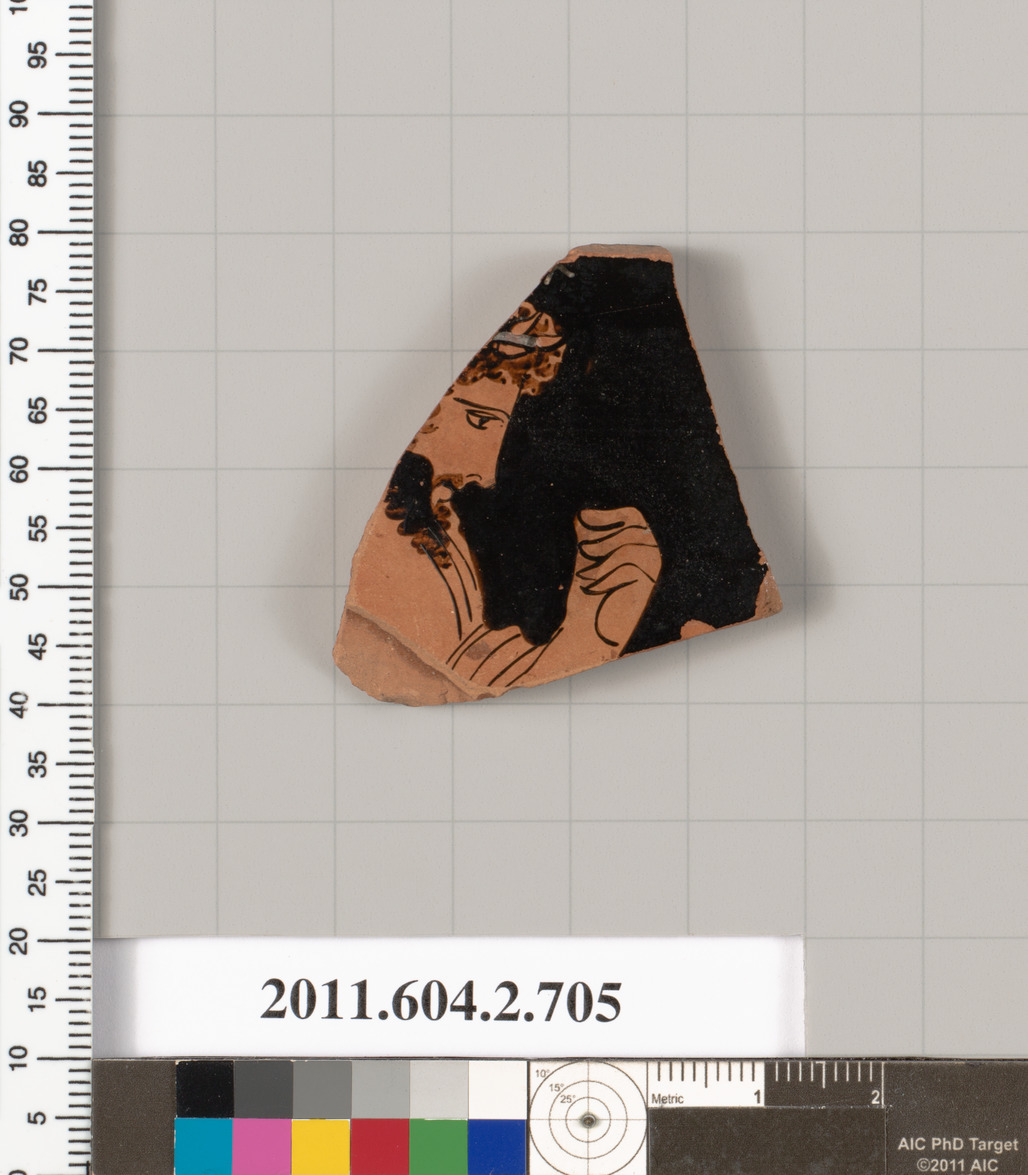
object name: calyx krater fragment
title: Terracotta fragment of a calyx-krater (bowl for mixing wine and water)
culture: greek, attic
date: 467-435 BCE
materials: terracotta